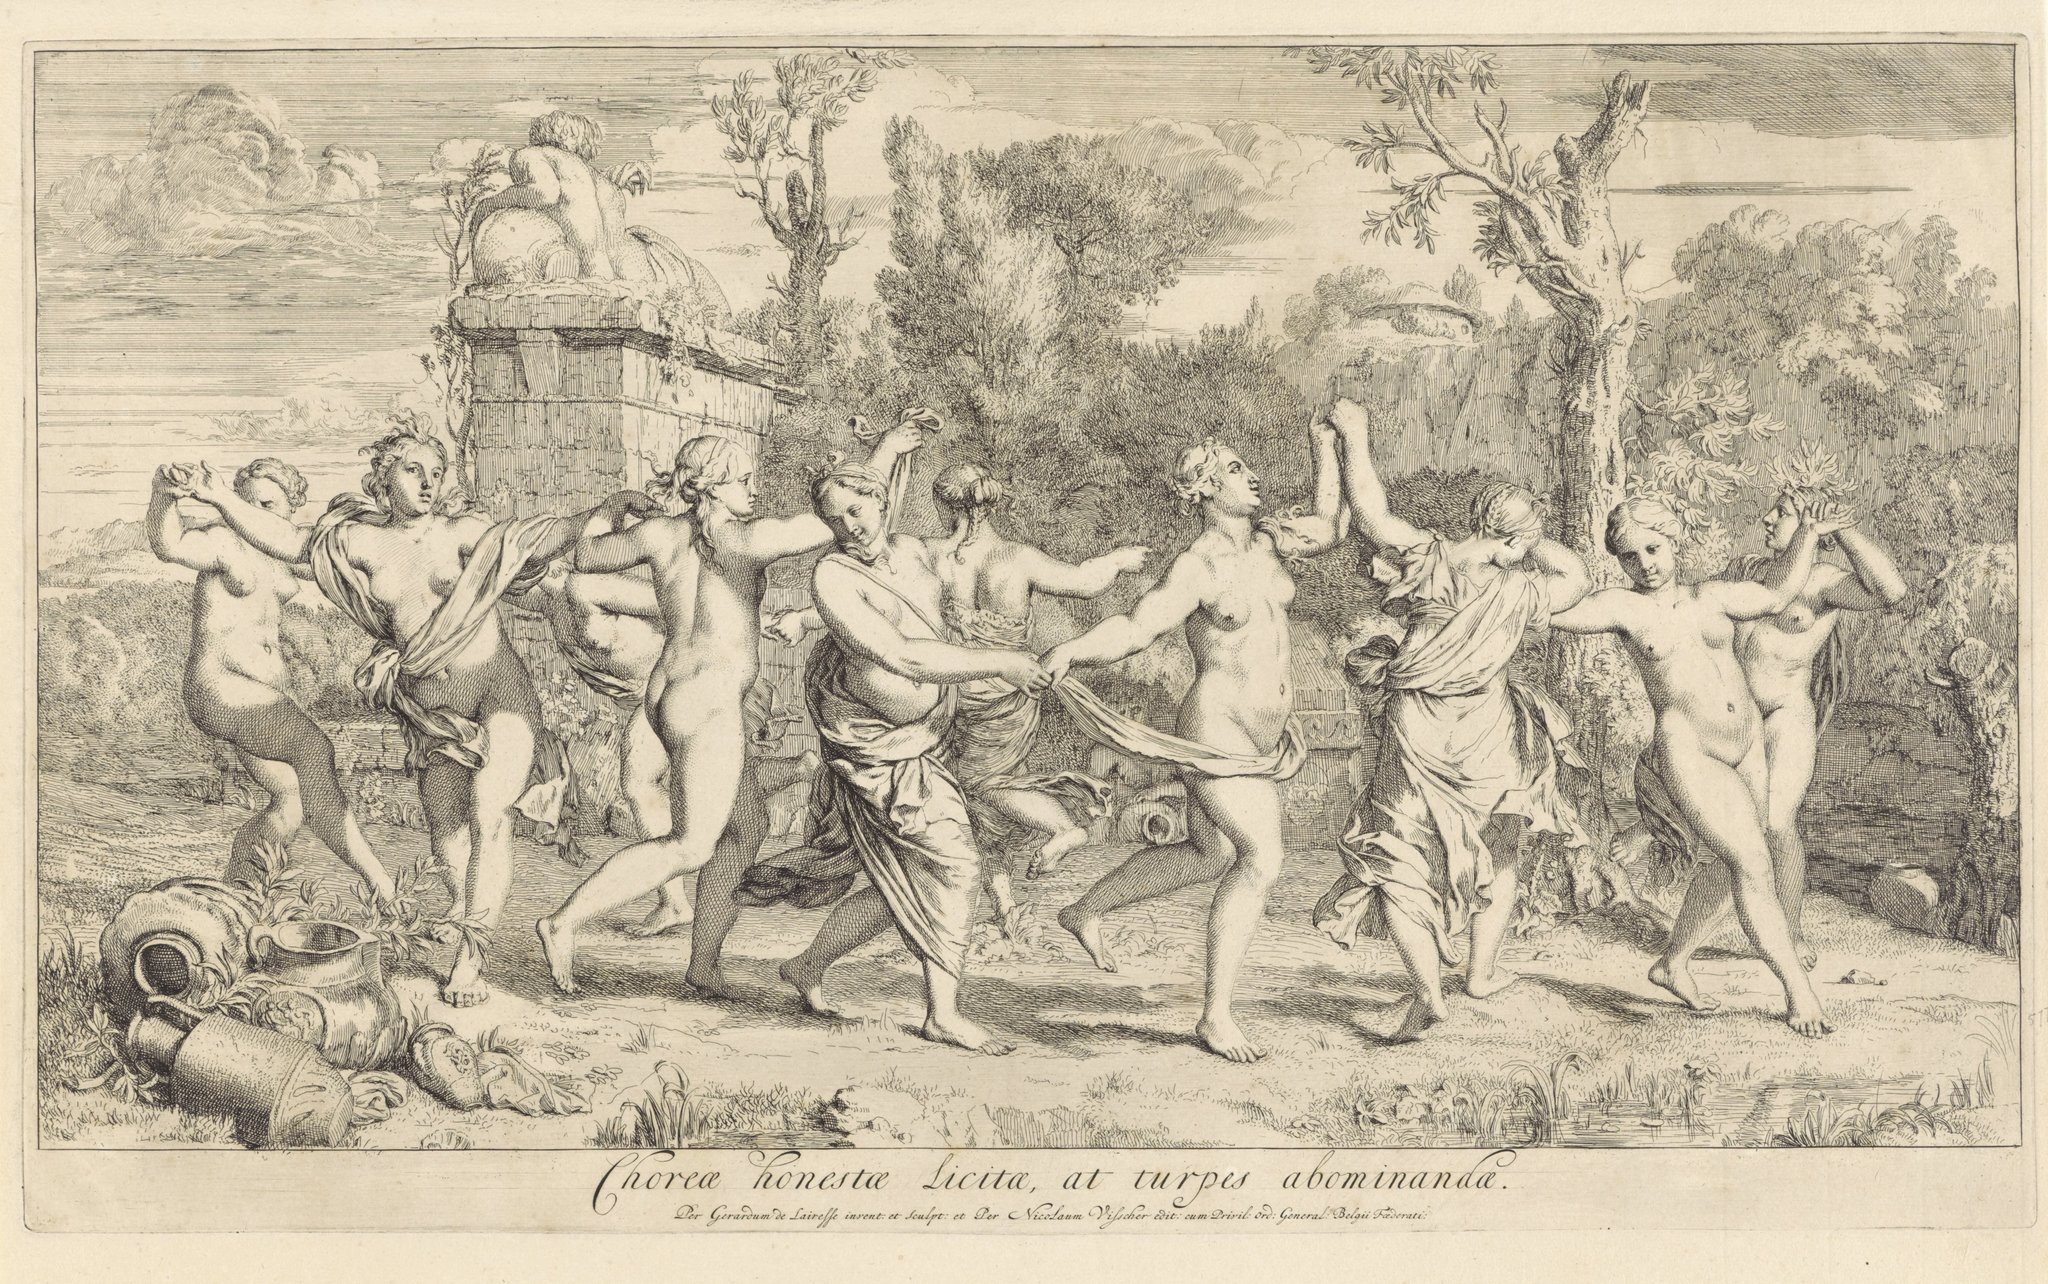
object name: print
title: Dansende nimfen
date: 1685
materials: paper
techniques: etching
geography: amsterdam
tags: dancing (+ out of doors (sports, games, etc.)), nymphs (in general); 'ninfe in commune' (ripa), river-gods, monument, statue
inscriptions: collector's mark: Lugt 240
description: Tien nimfen dansen hand in hand in de natuur. Op de achtergrond een muurtje waarop een liggend beeld van een riviergod is geplaatst.